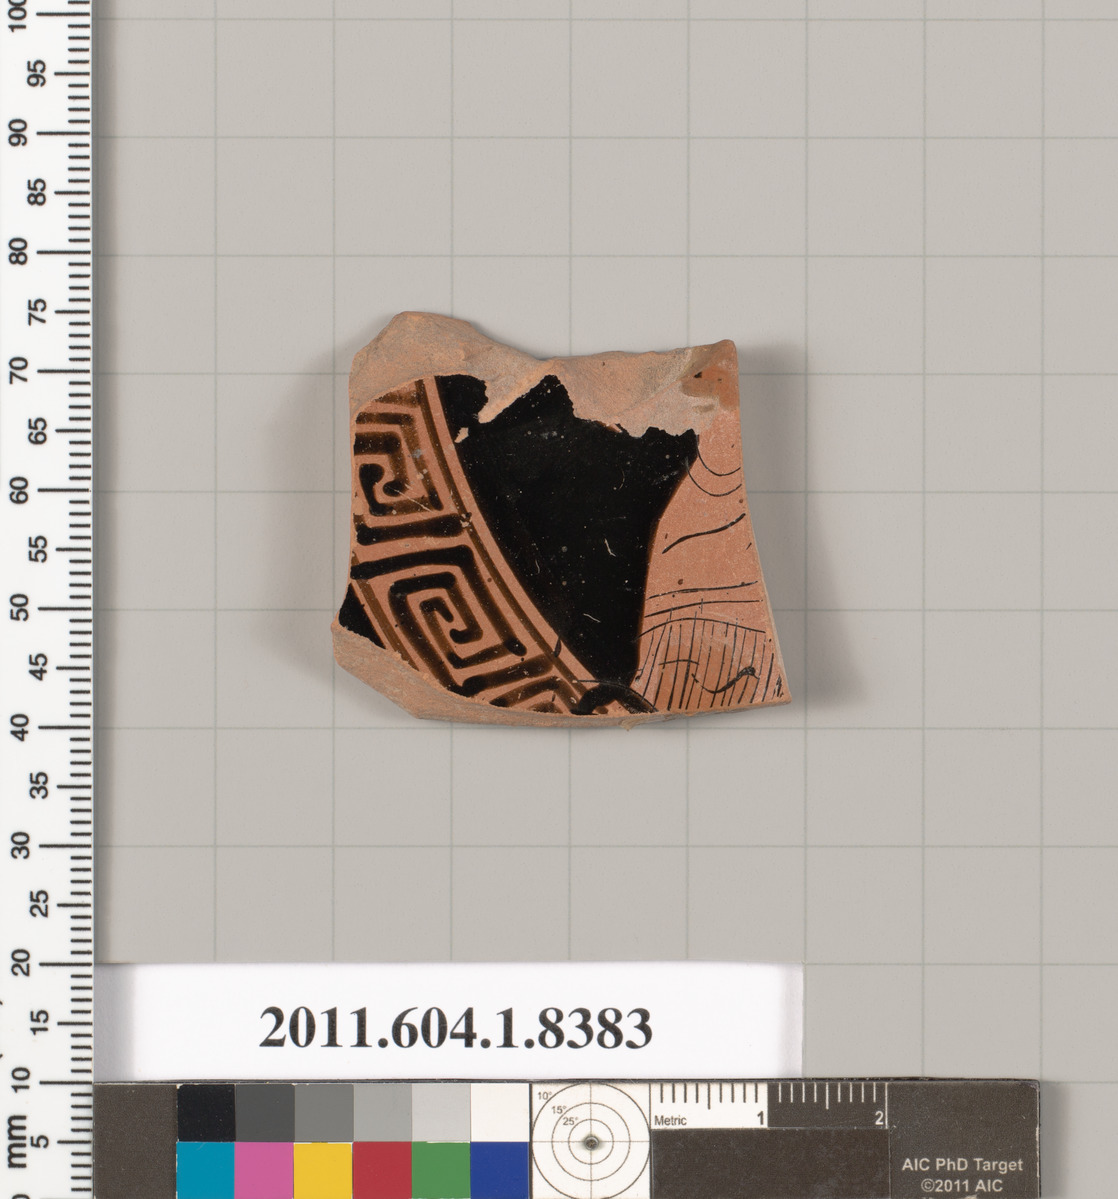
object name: kylix fragment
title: Terracotta fragment of a kylix (drinking cup)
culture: greek, attic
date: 410-390 BCE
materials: terracotta